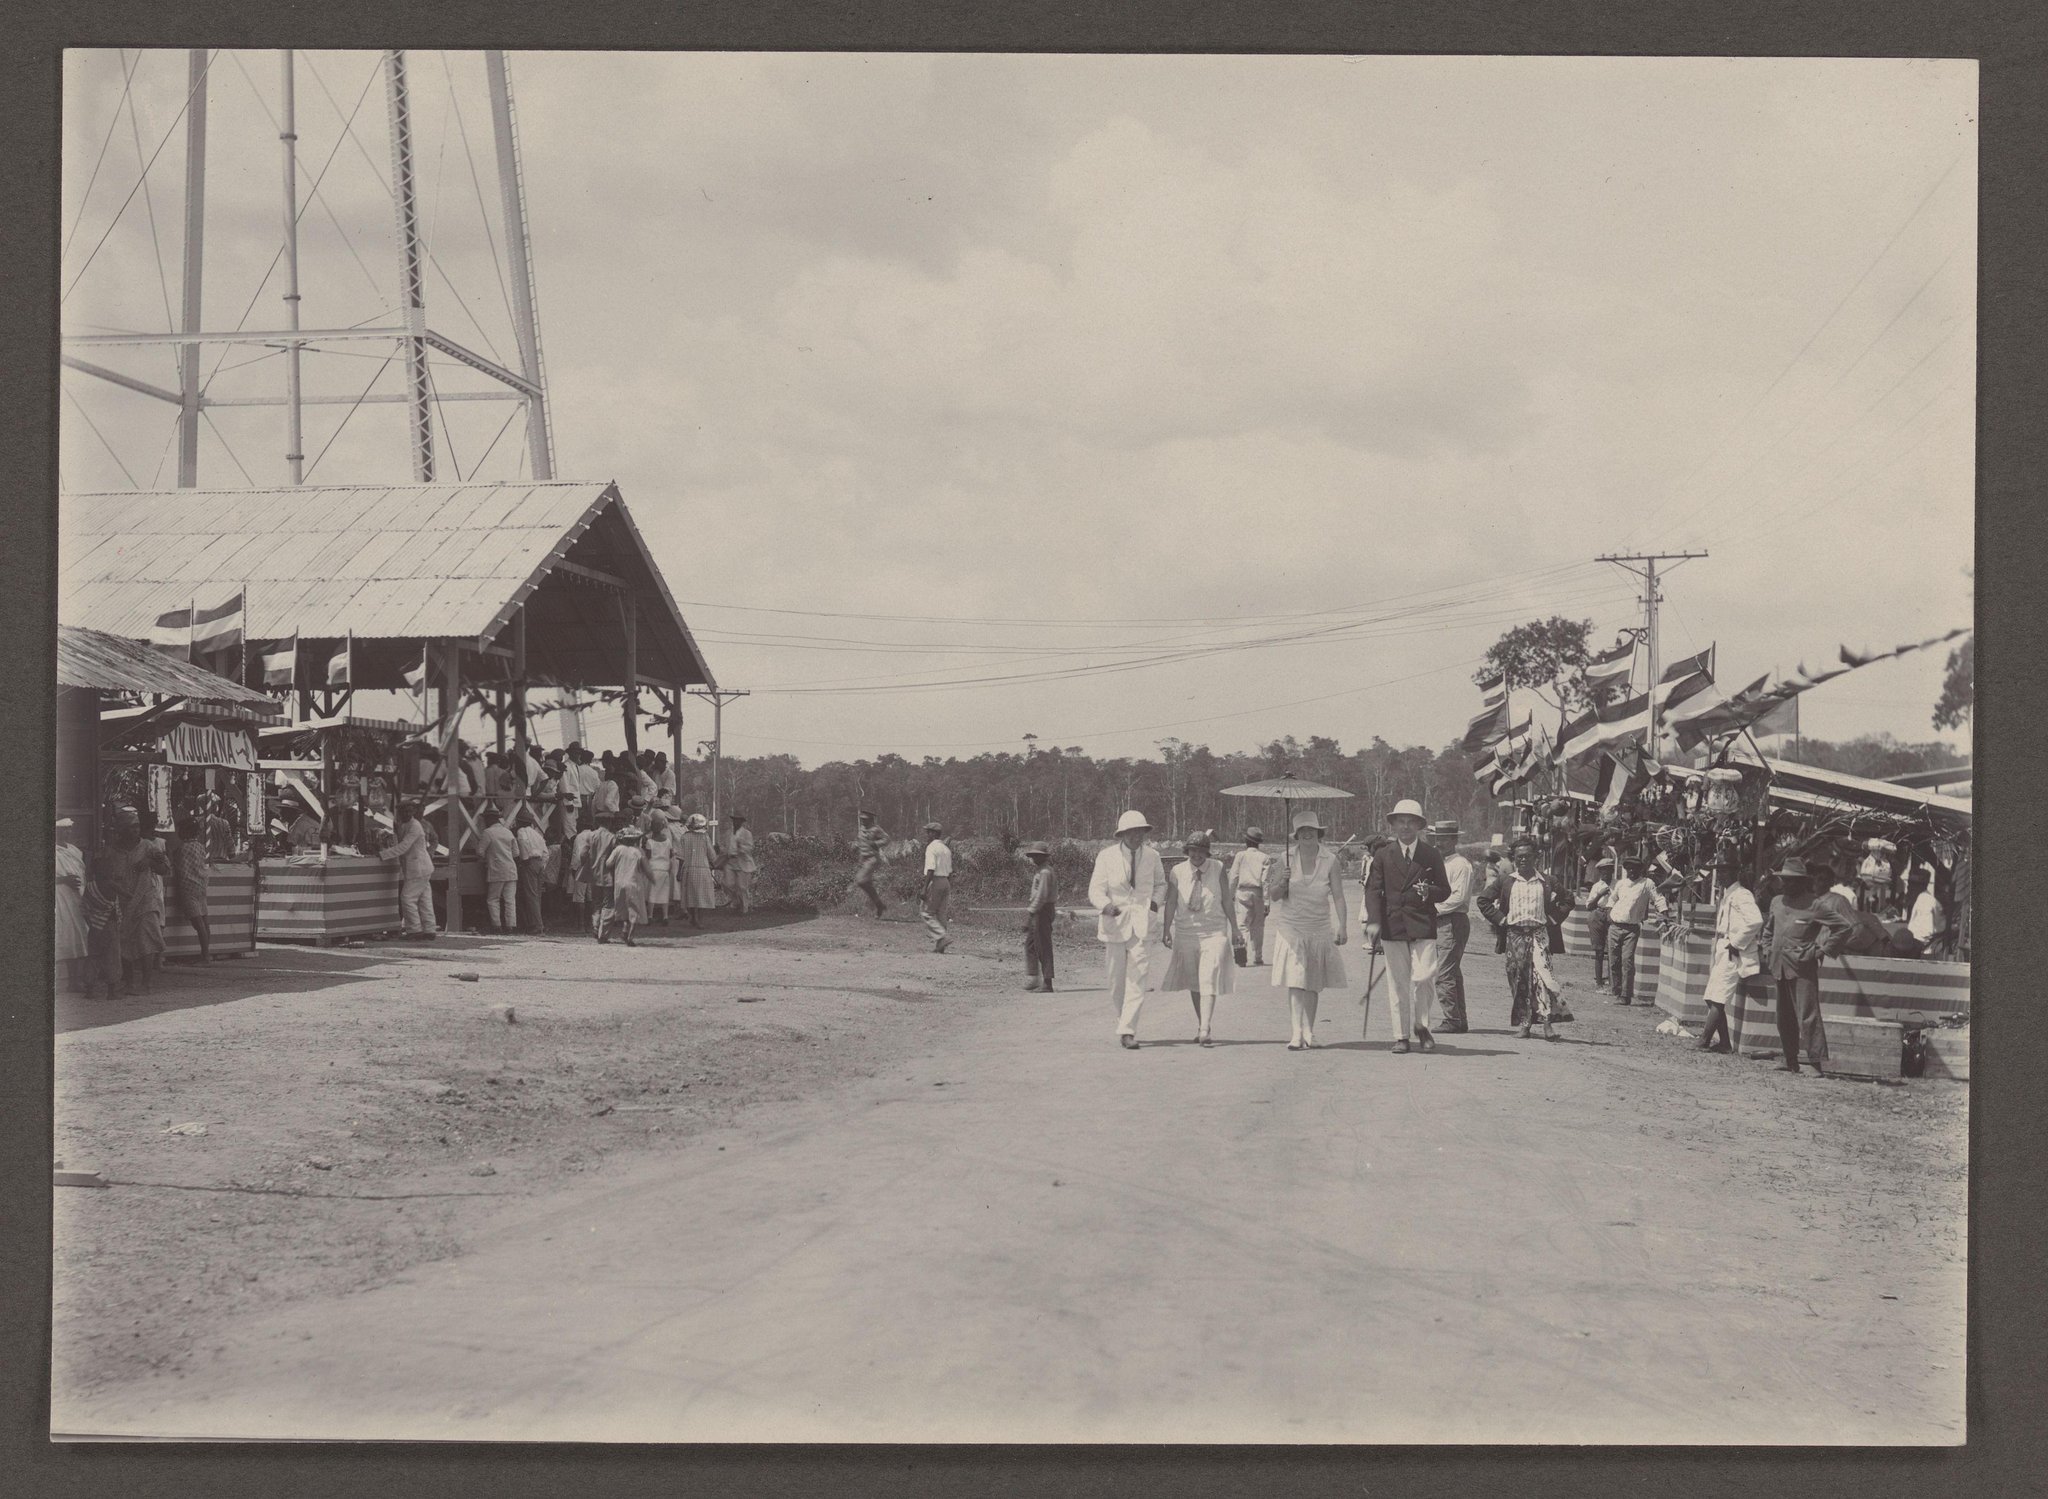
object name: photograph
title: Hoog bezoek aan de mijn en fabriek te Moengo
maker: Anonymous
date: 1925-1927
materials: photographic support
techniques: photography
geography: suriname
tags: jetten, familie, moengo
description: Hoog bezoek begeleid door de heer en mevrouw Jetten over het terrein van de mijn en fabriek te Moengo. Op het fabrieksterrein zijn allerlei feestelijkheden aan de gang, links een stalletje van de voetbalclub V.V. Juliana. Foto op een bladzijde van een los albumblad. Onderdeel van het ensemble met foto's van de familie van ingenieur Jetten in de mijnbouwstad Moengo in Suriname.